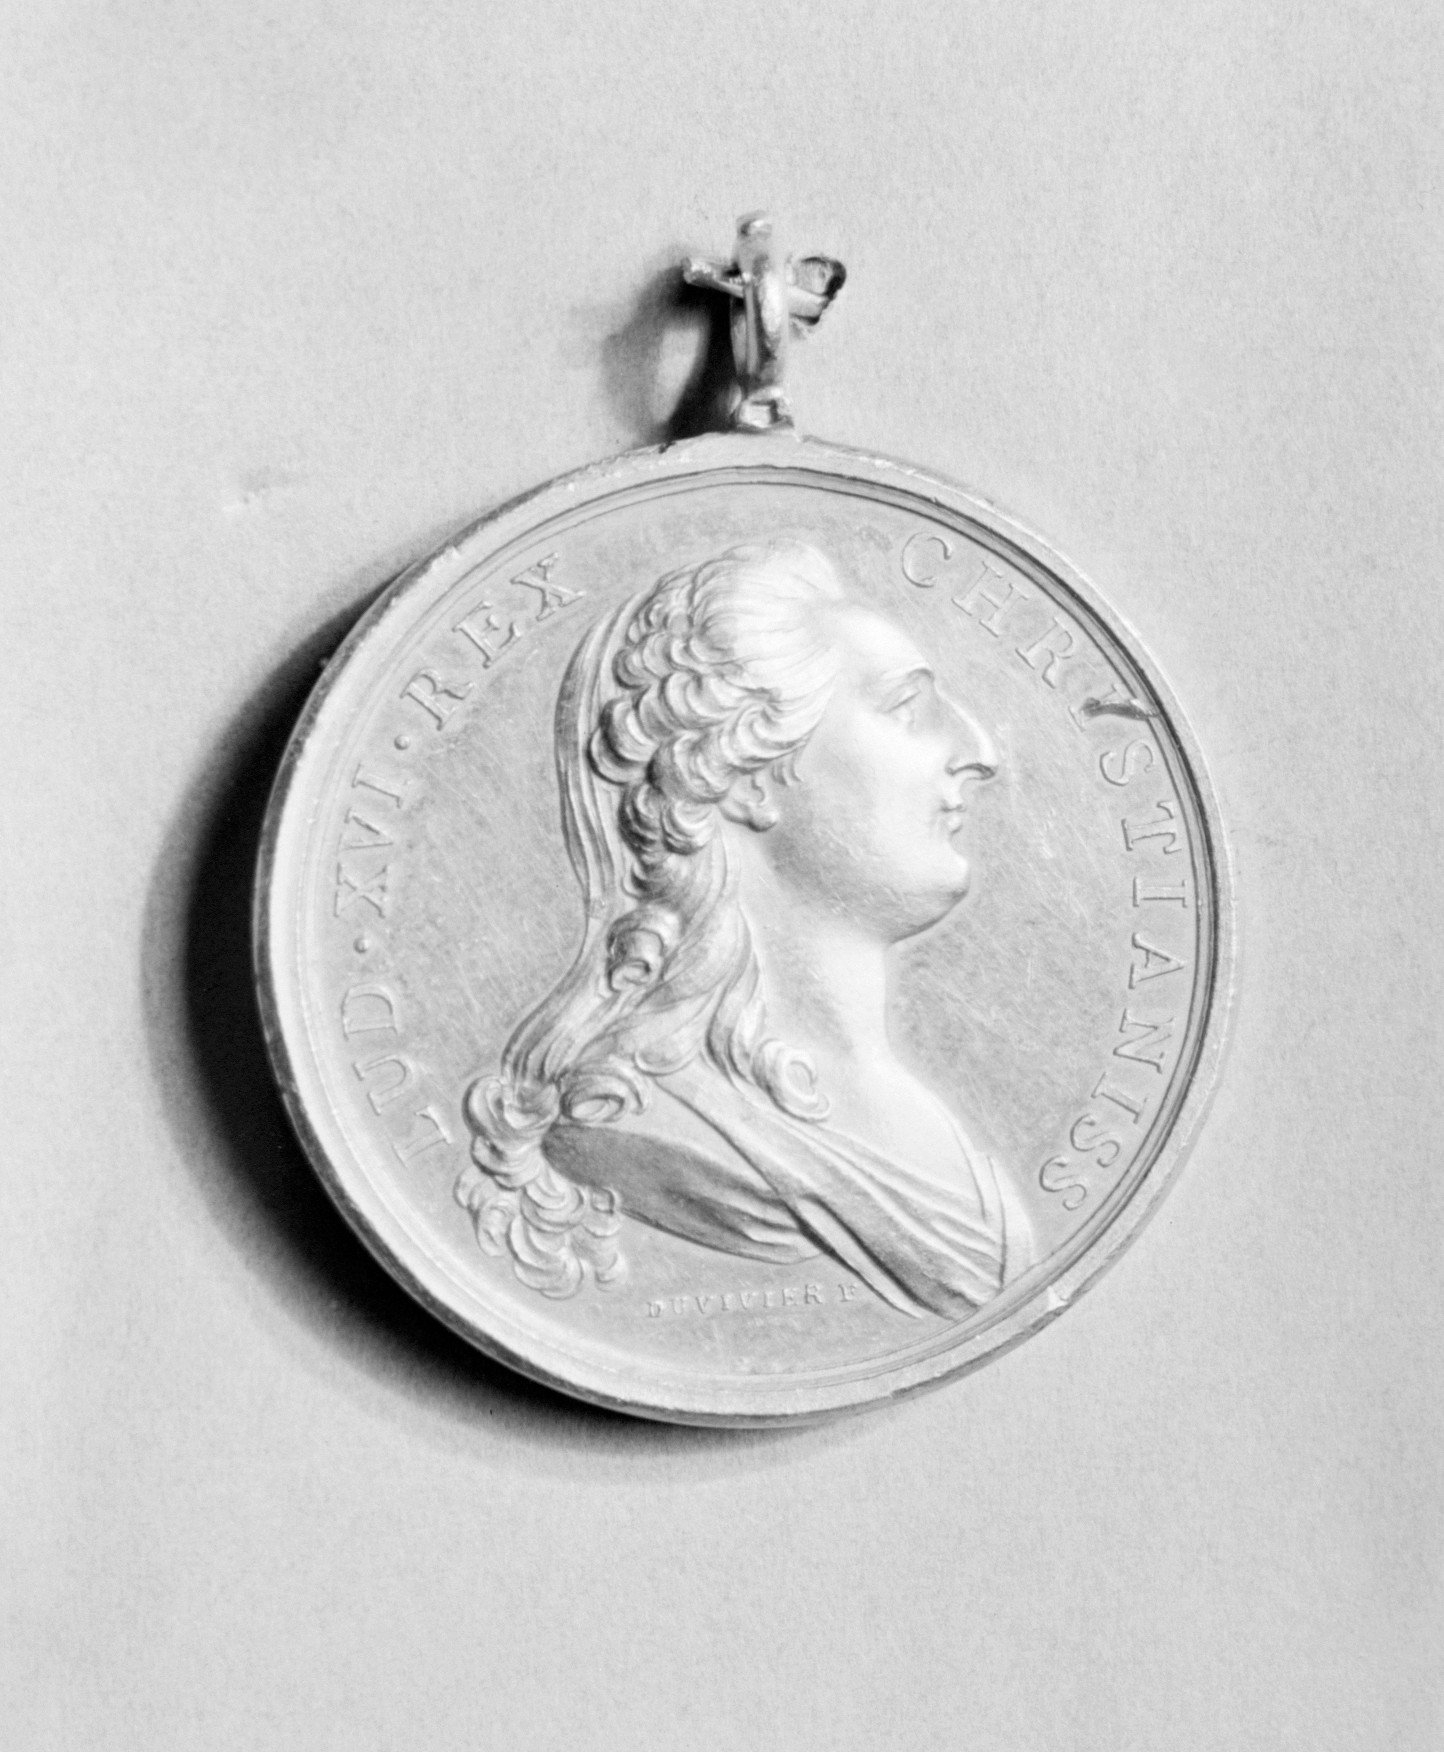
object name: medal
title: Louis XVI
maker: jean duvivier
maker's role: artist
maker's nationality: french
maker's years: 1687-1761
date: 1777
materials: gilt bronze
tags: men,profiles